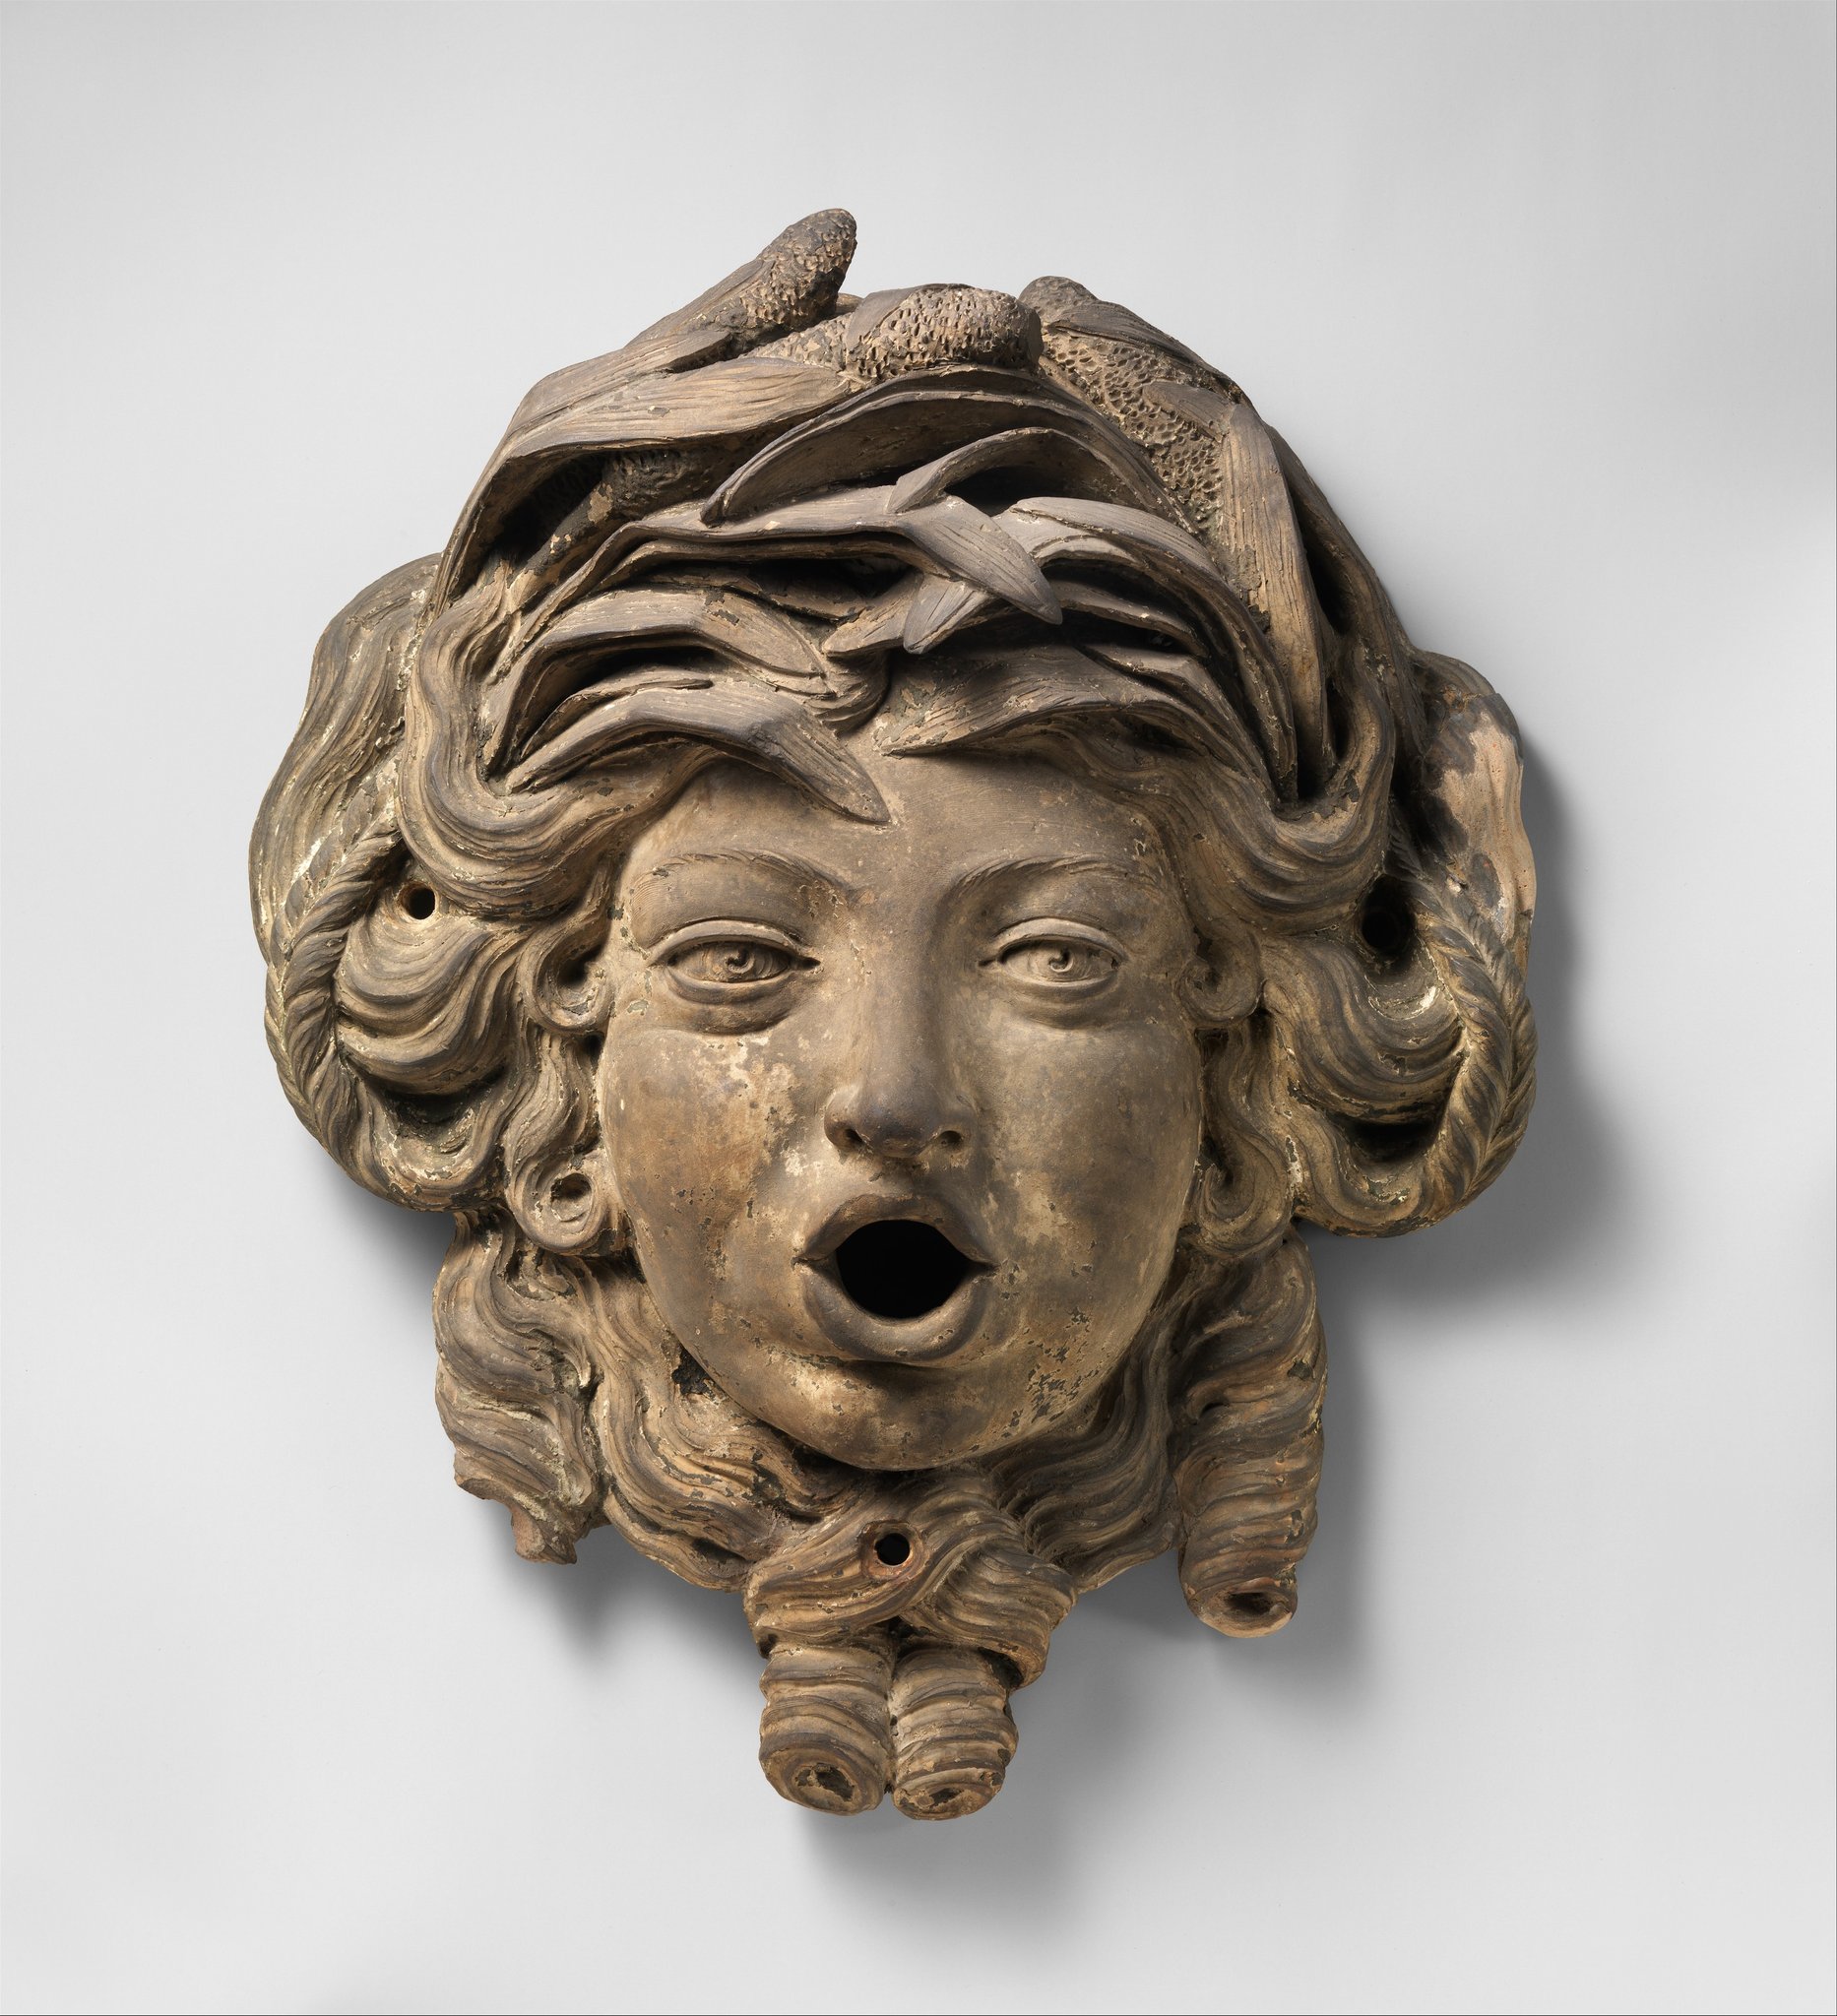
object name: mascaron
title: Female head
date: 1701-1733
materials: terracotta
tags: heads,women